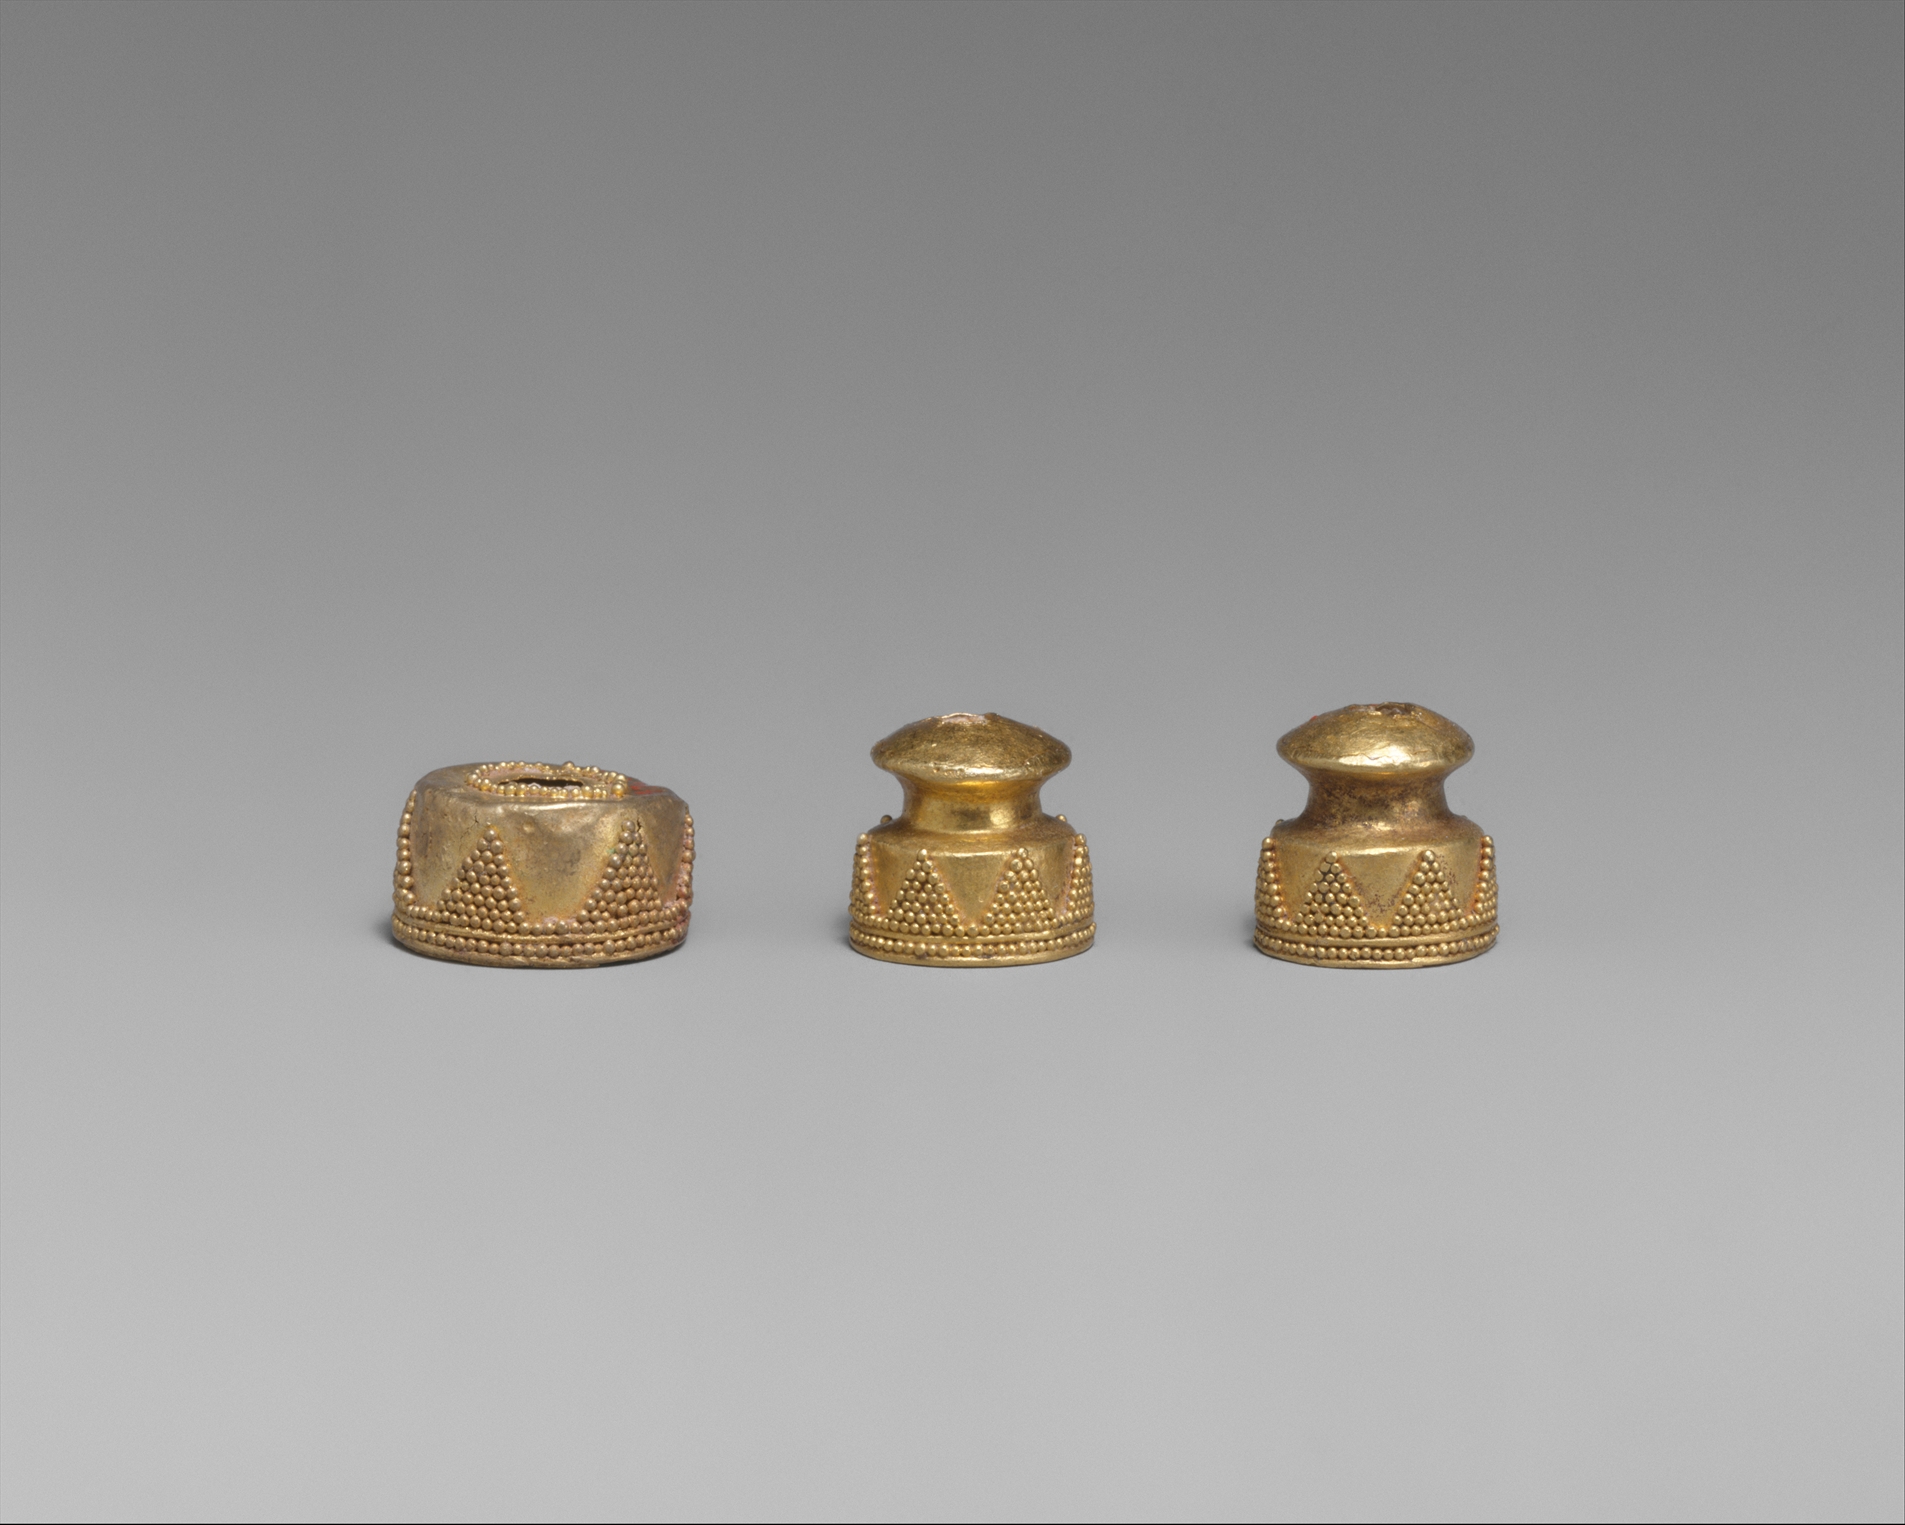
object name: cylinder seal cap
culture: babylonian or kassite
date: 1700-1501 BCE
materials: gold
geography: mesopotamia